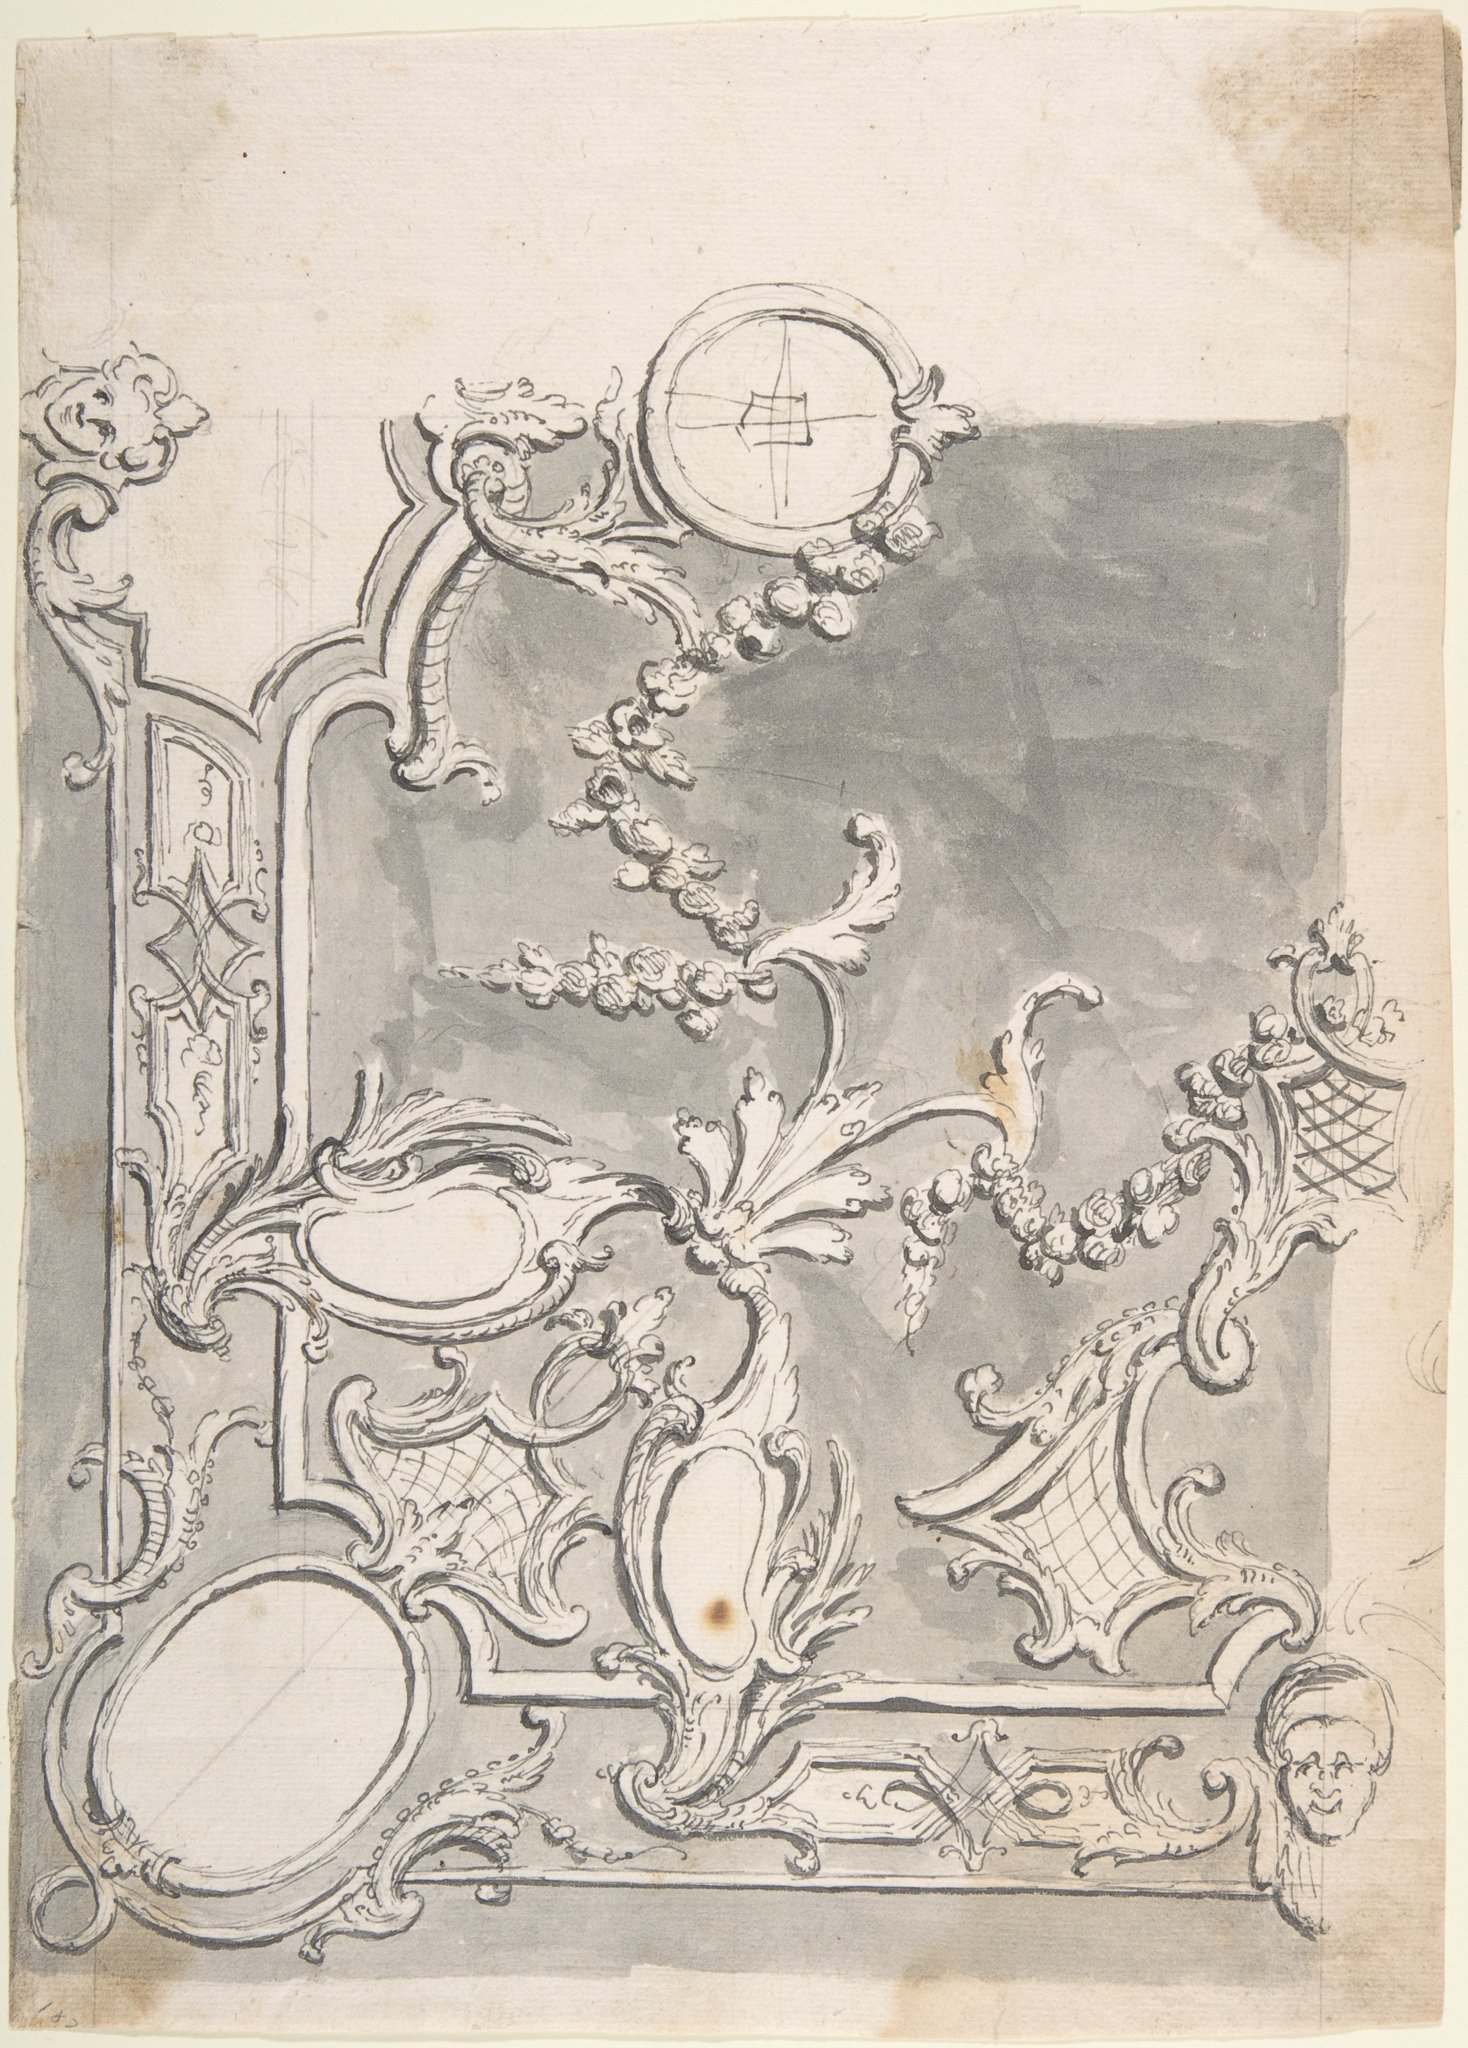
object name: drawing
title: One Quarter of a Design for Corner of a Wall or a Ceiling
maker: anonymous, italian, piedmontese, 18th century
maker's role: artist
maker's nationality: italian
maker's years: 1700-1800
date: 1700-1780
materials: graphite, ink, drawing material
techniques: brush, pen, wash